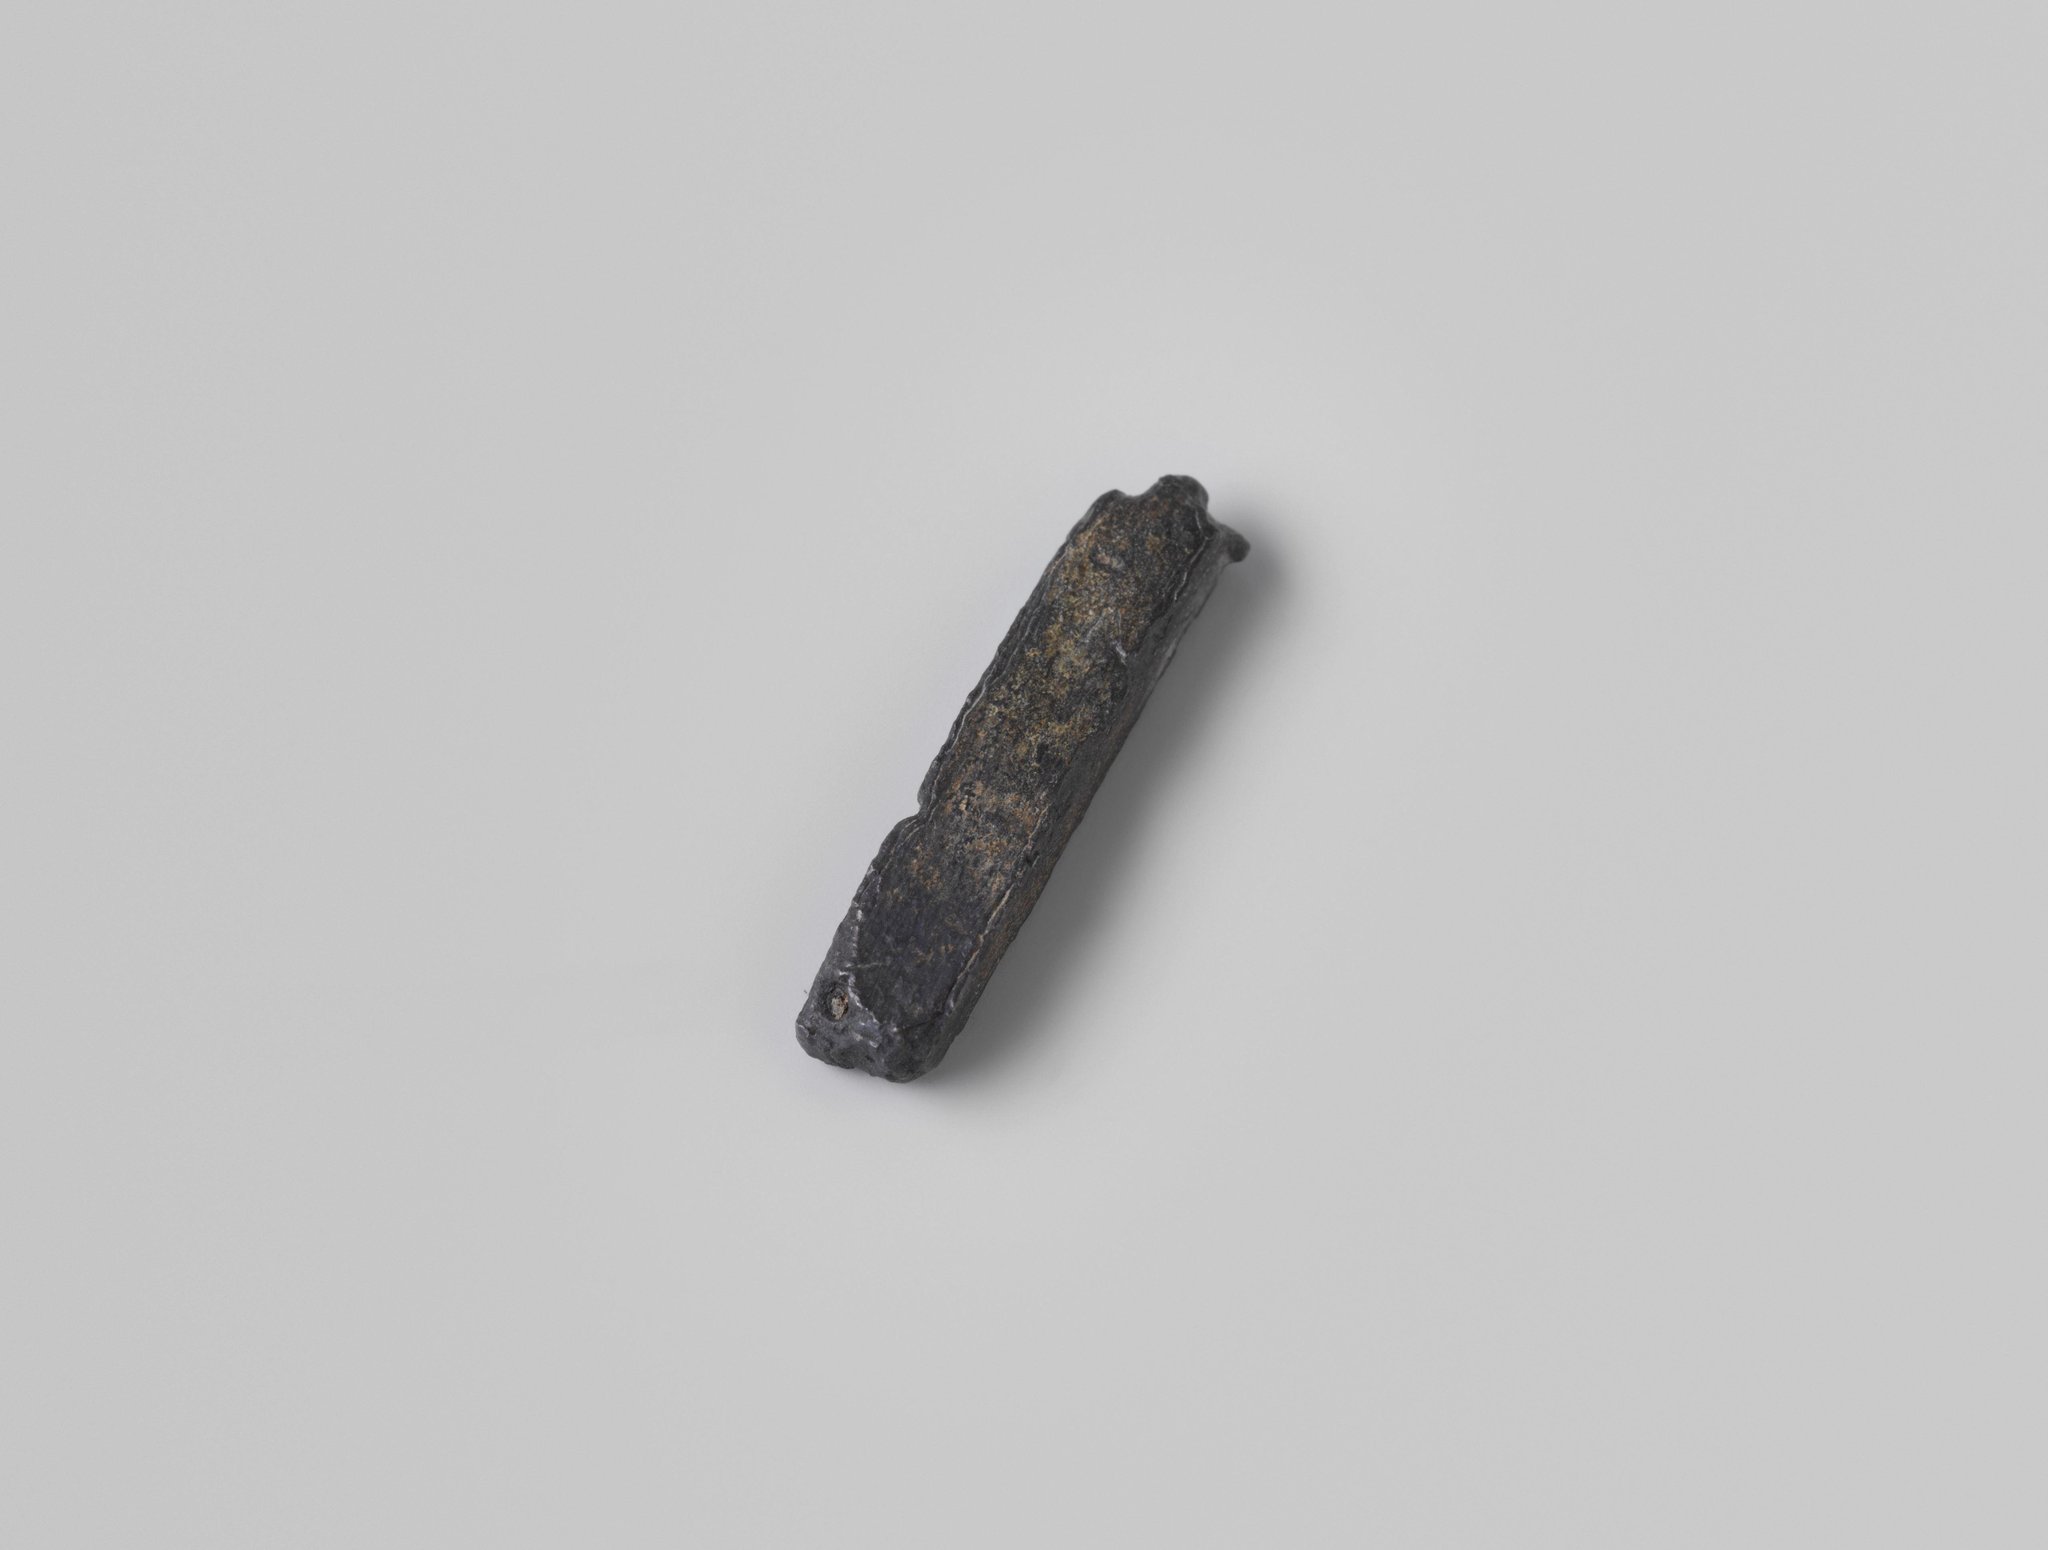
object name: type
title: Drukletter uit het wrak van de Oost-Indiëvaarder Hollandia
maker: Anonymous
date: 1700-1743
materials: lead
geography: netherlands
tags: verenigde oostindische compagnie, hollandia (schip), annet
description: Printing type, rectangular, groove in one side, illegable.